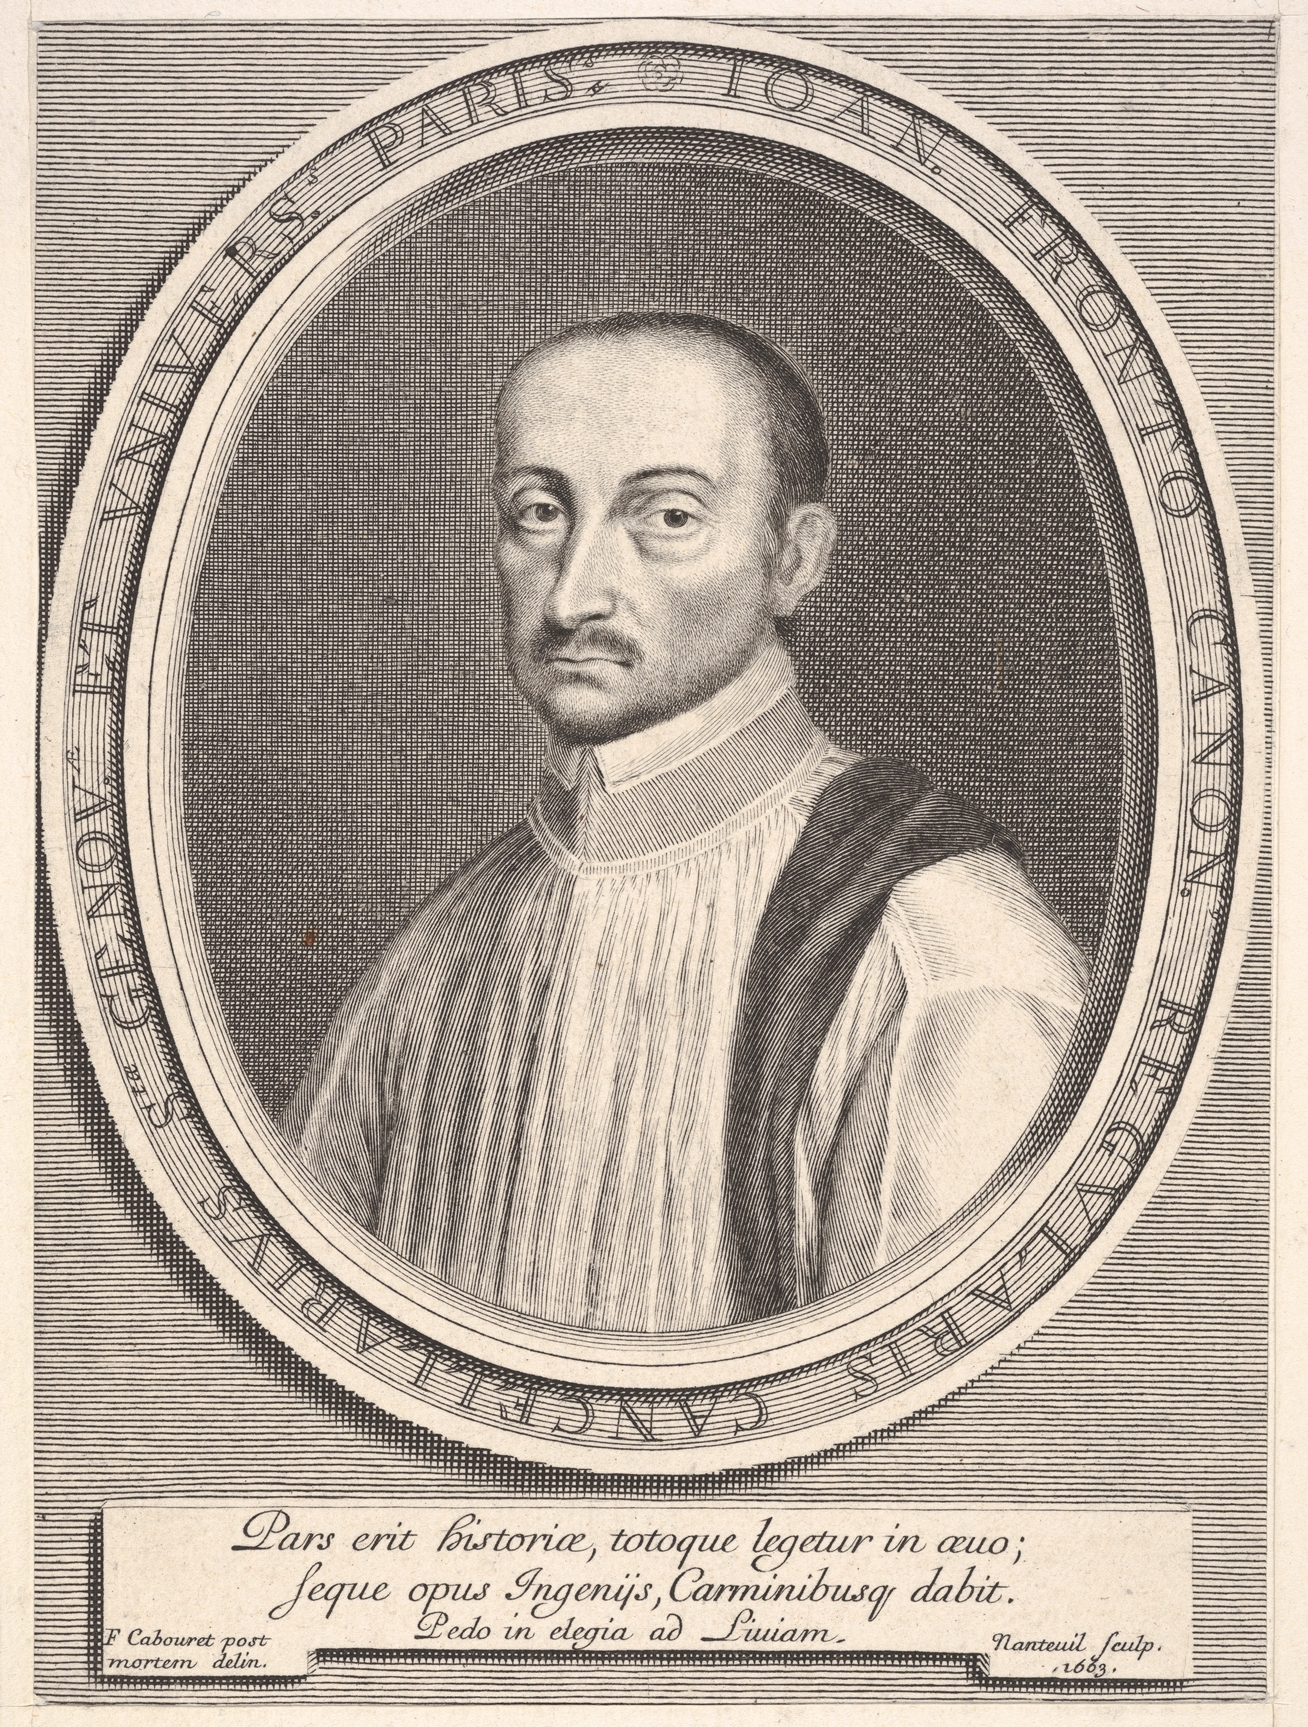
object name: print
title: Jean Fronteau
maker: robert nanteuil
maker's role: artist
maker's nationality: french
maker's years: 1623-1678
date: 1663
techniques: engraving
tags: men,portraits